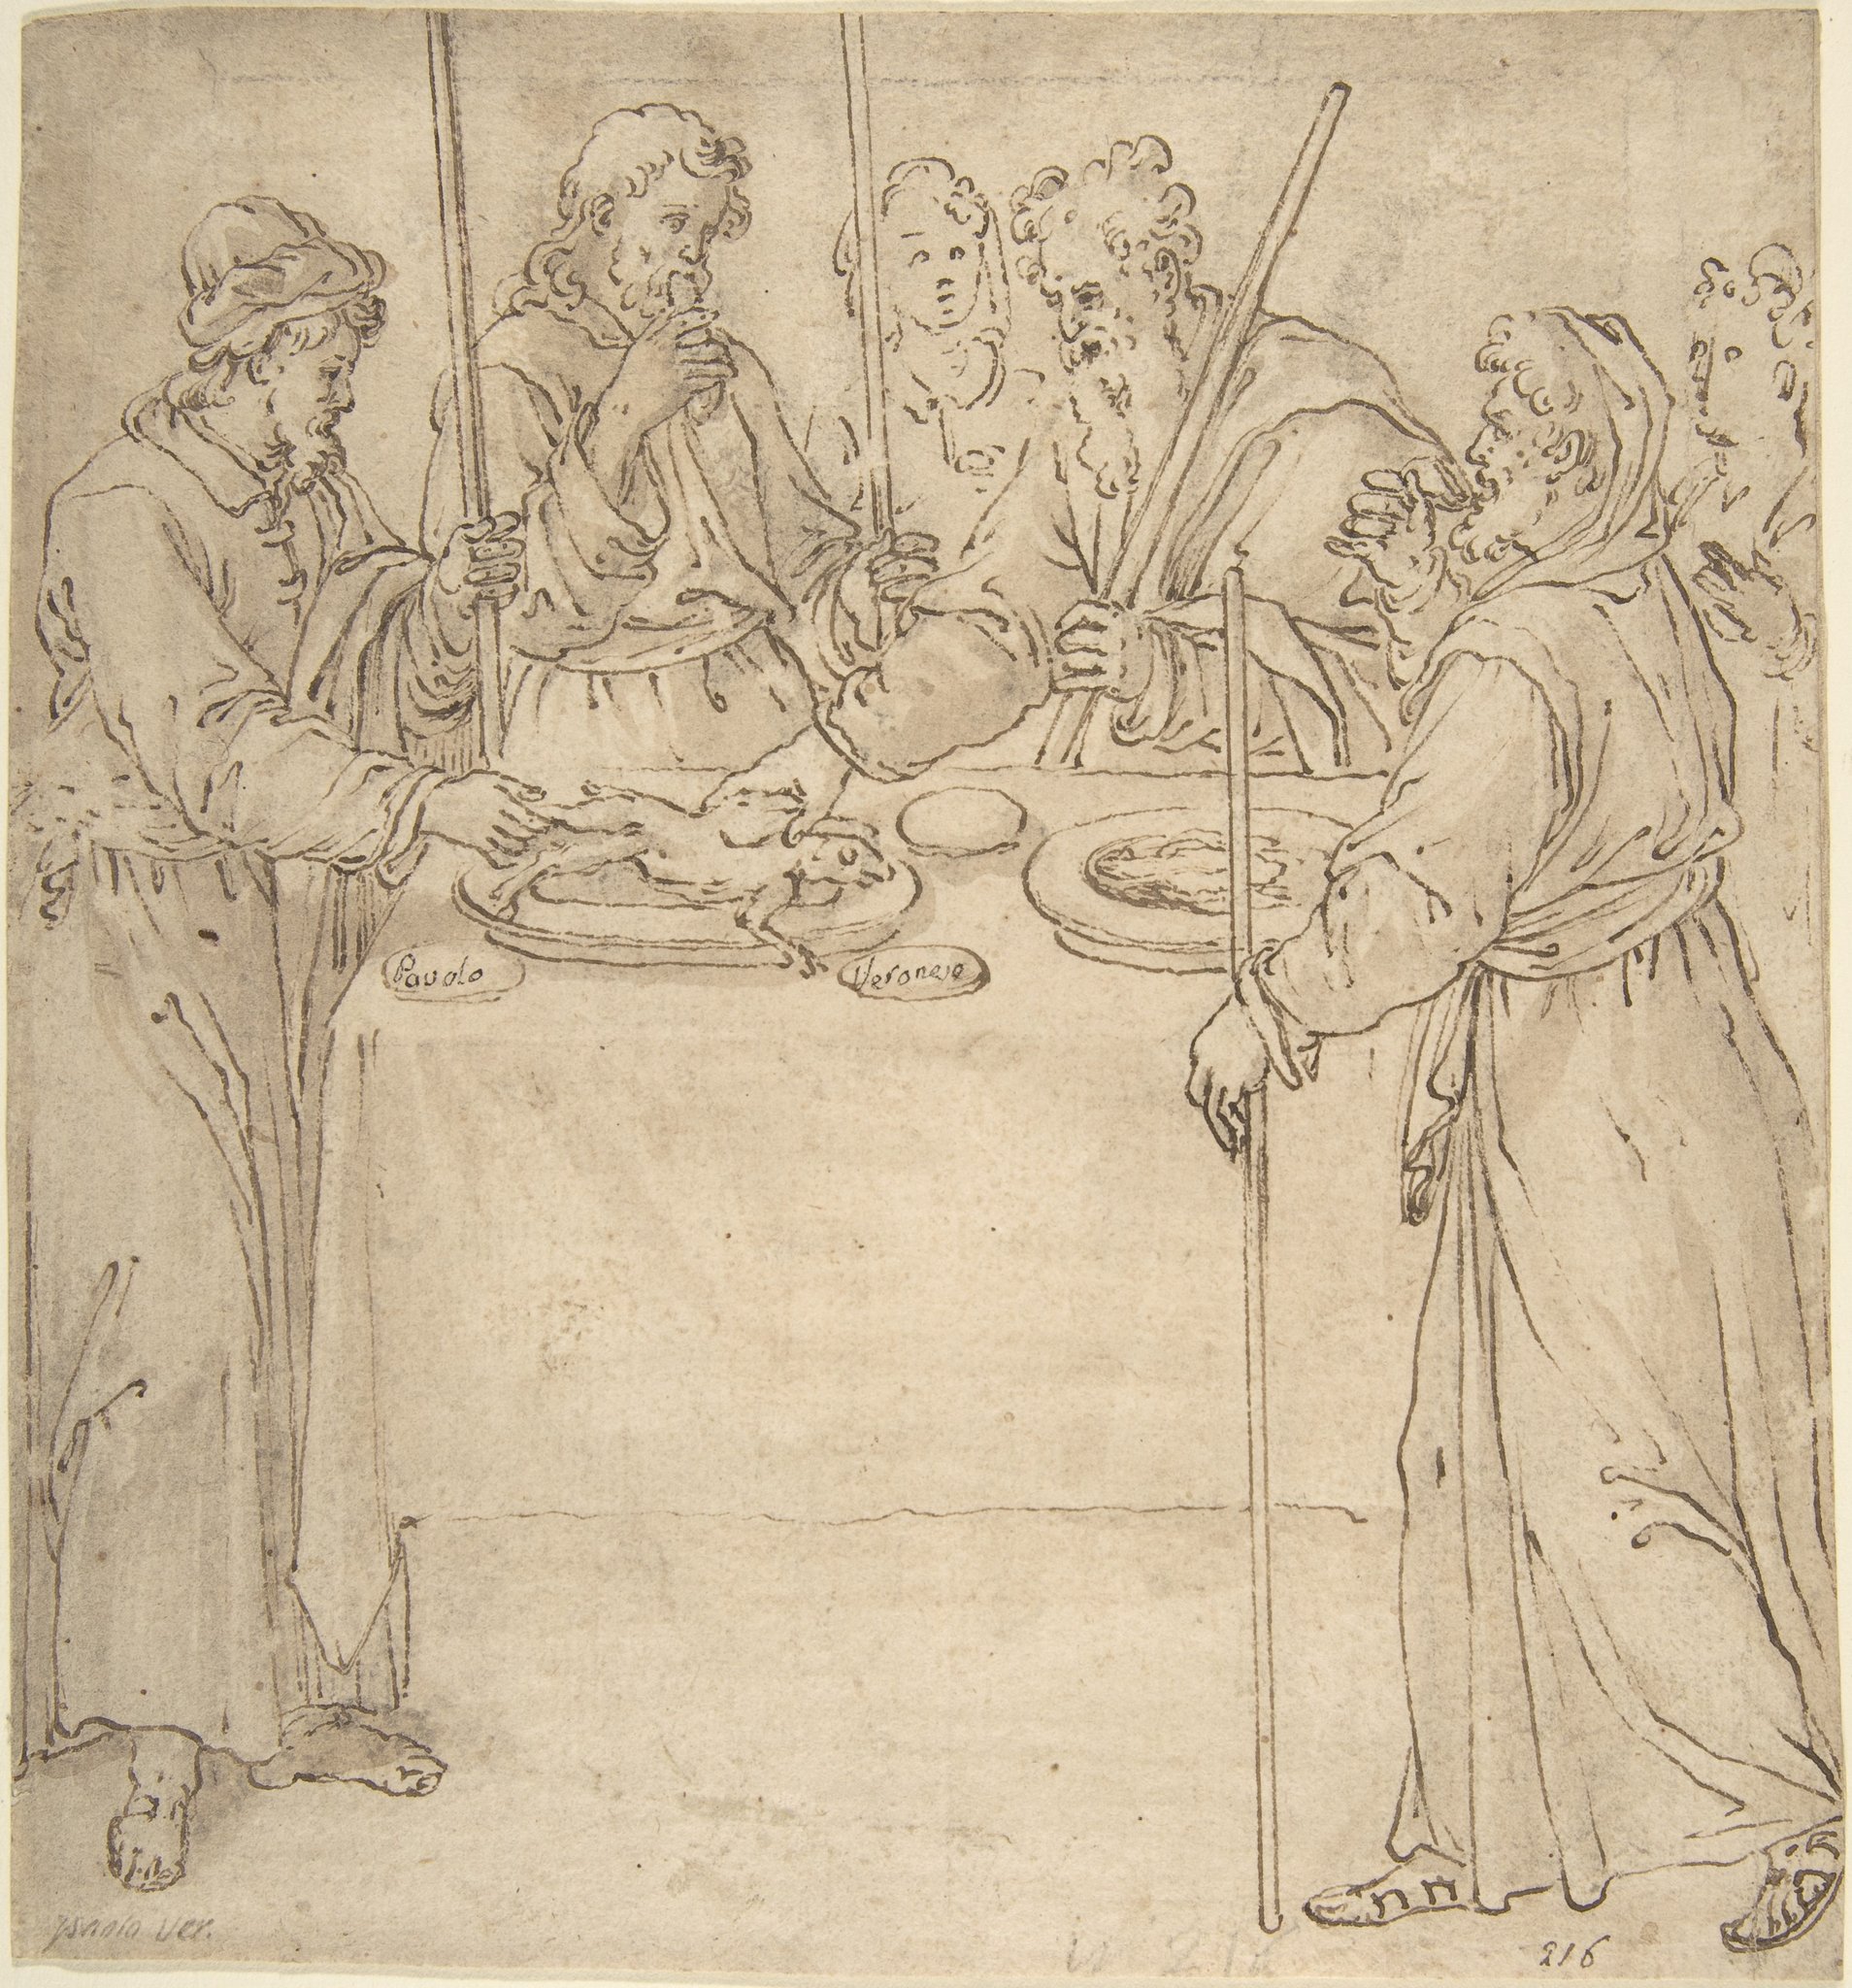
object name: drawing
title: Four Travelers Sharing a Meal?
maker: anonymous, italian, mid-16th century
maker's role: artist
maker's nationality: italian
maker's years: 1520-1580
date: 1534-1566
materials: ink, drawing material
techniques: pen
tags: food,men